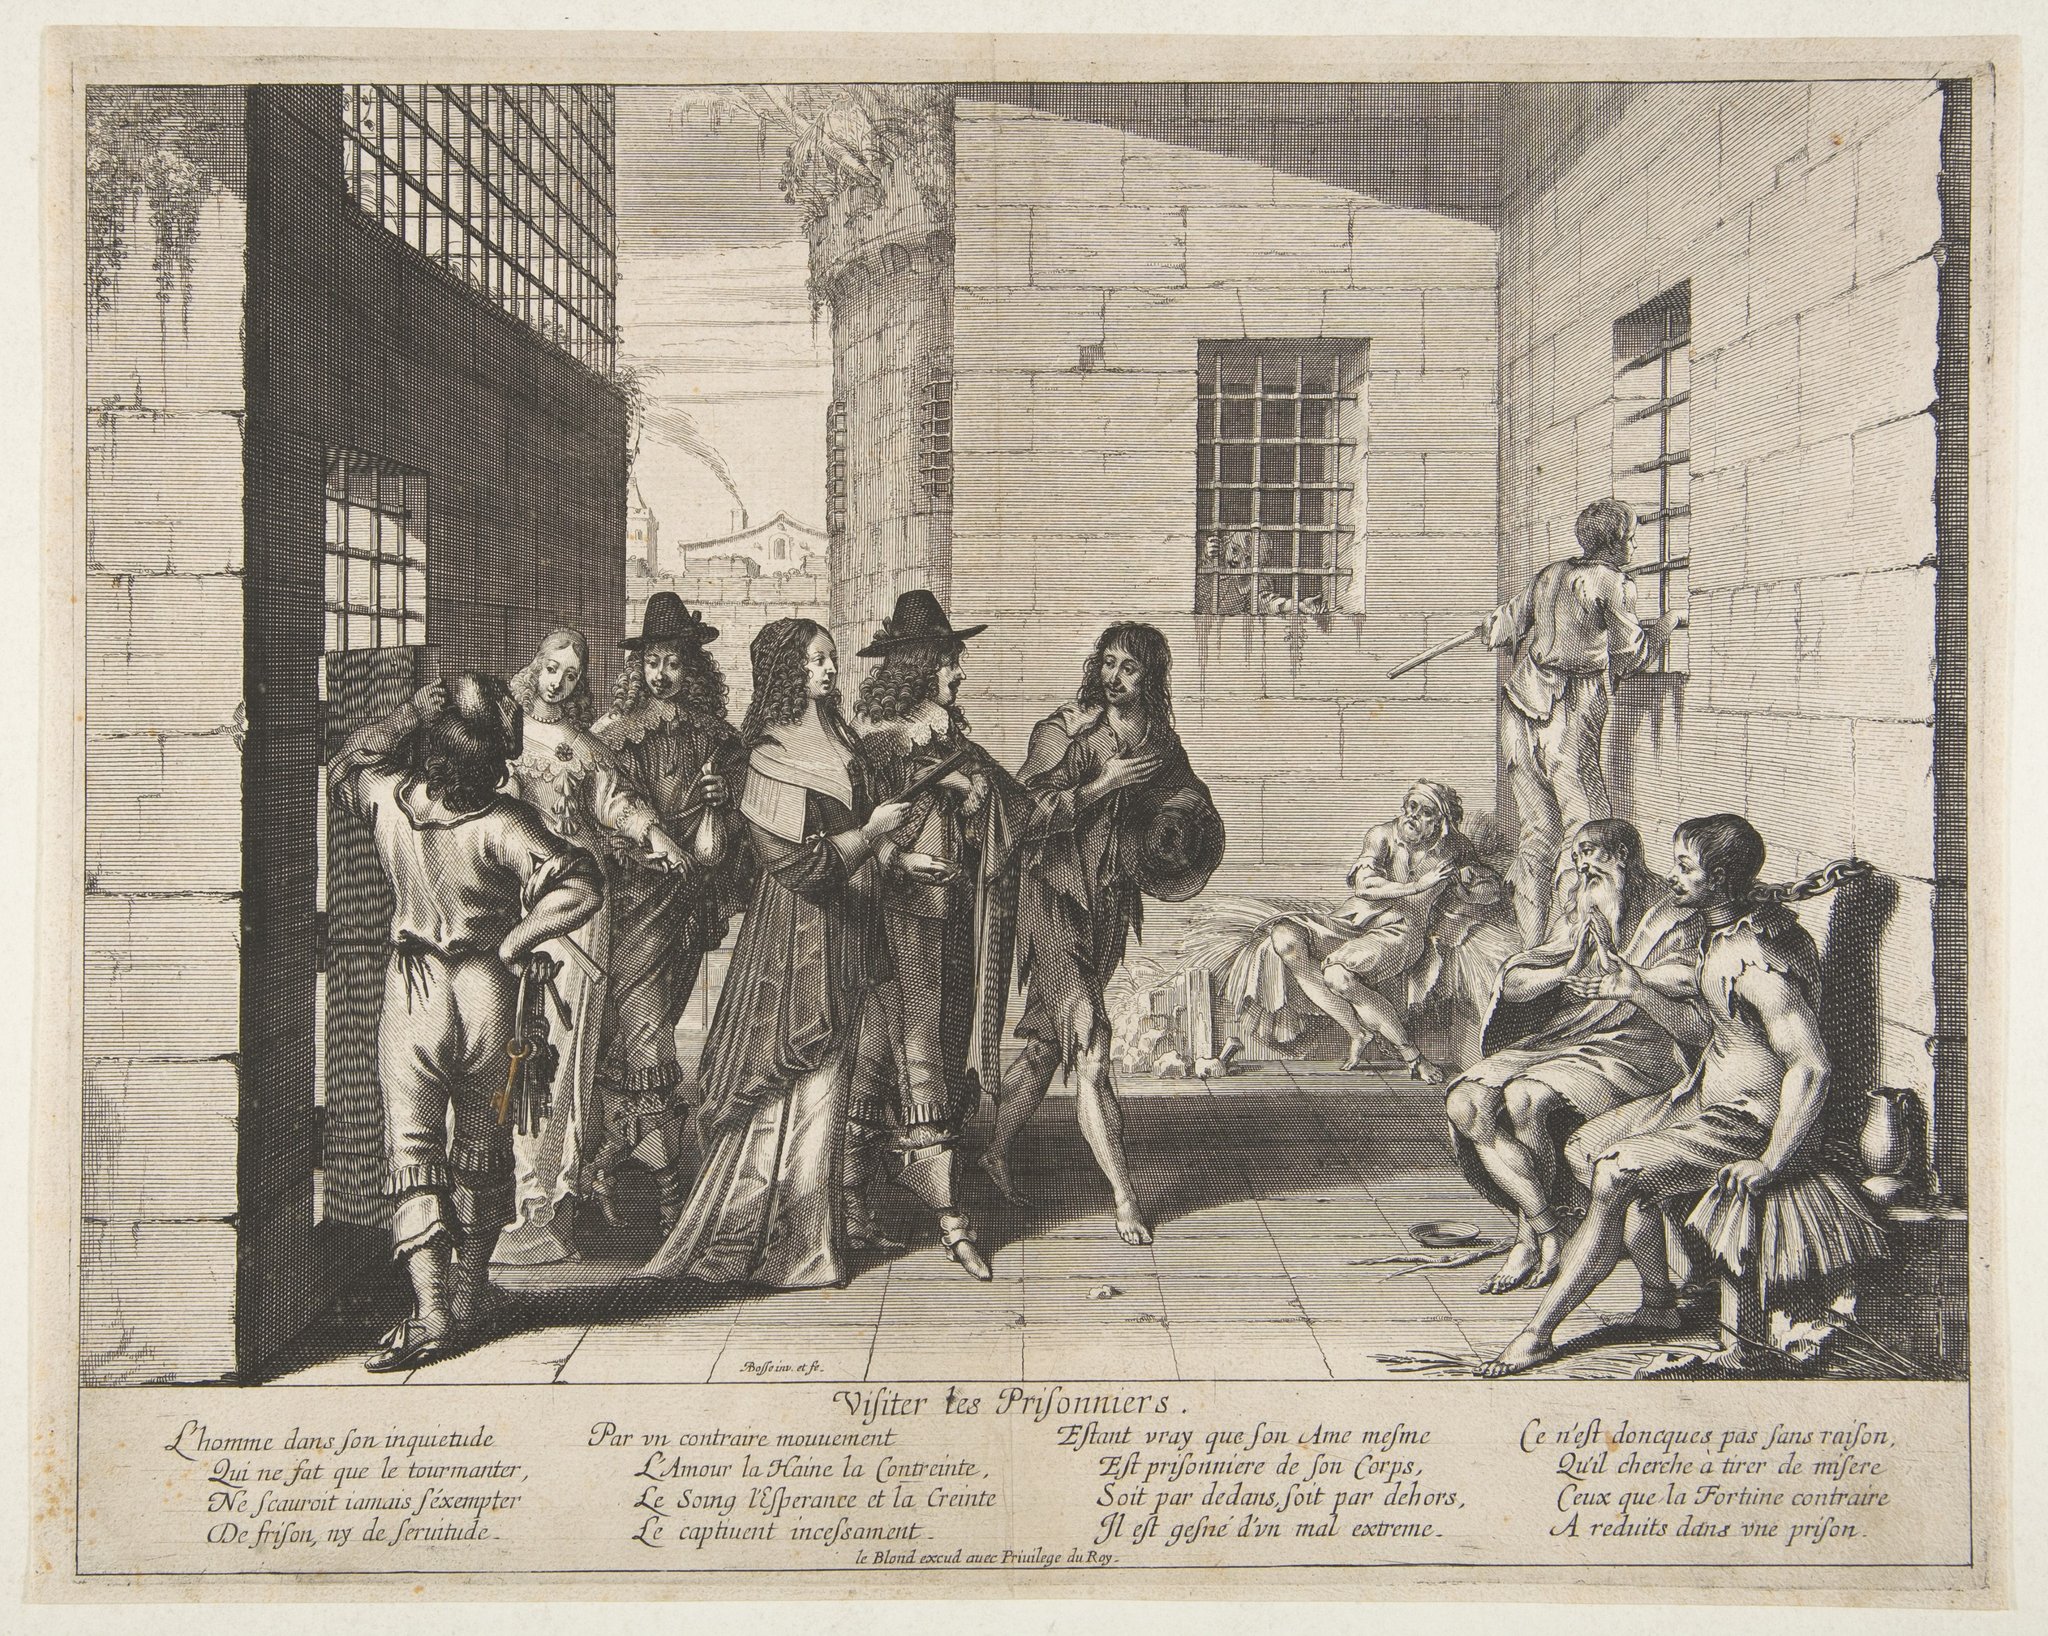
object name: print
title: Visiting the Prisoners (Visiter les prisonniers)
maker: abraham bosse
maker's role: artist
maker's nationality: french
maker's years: 1602-1676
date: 1602-1676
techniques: etching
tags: prisons,prisoners,men,women